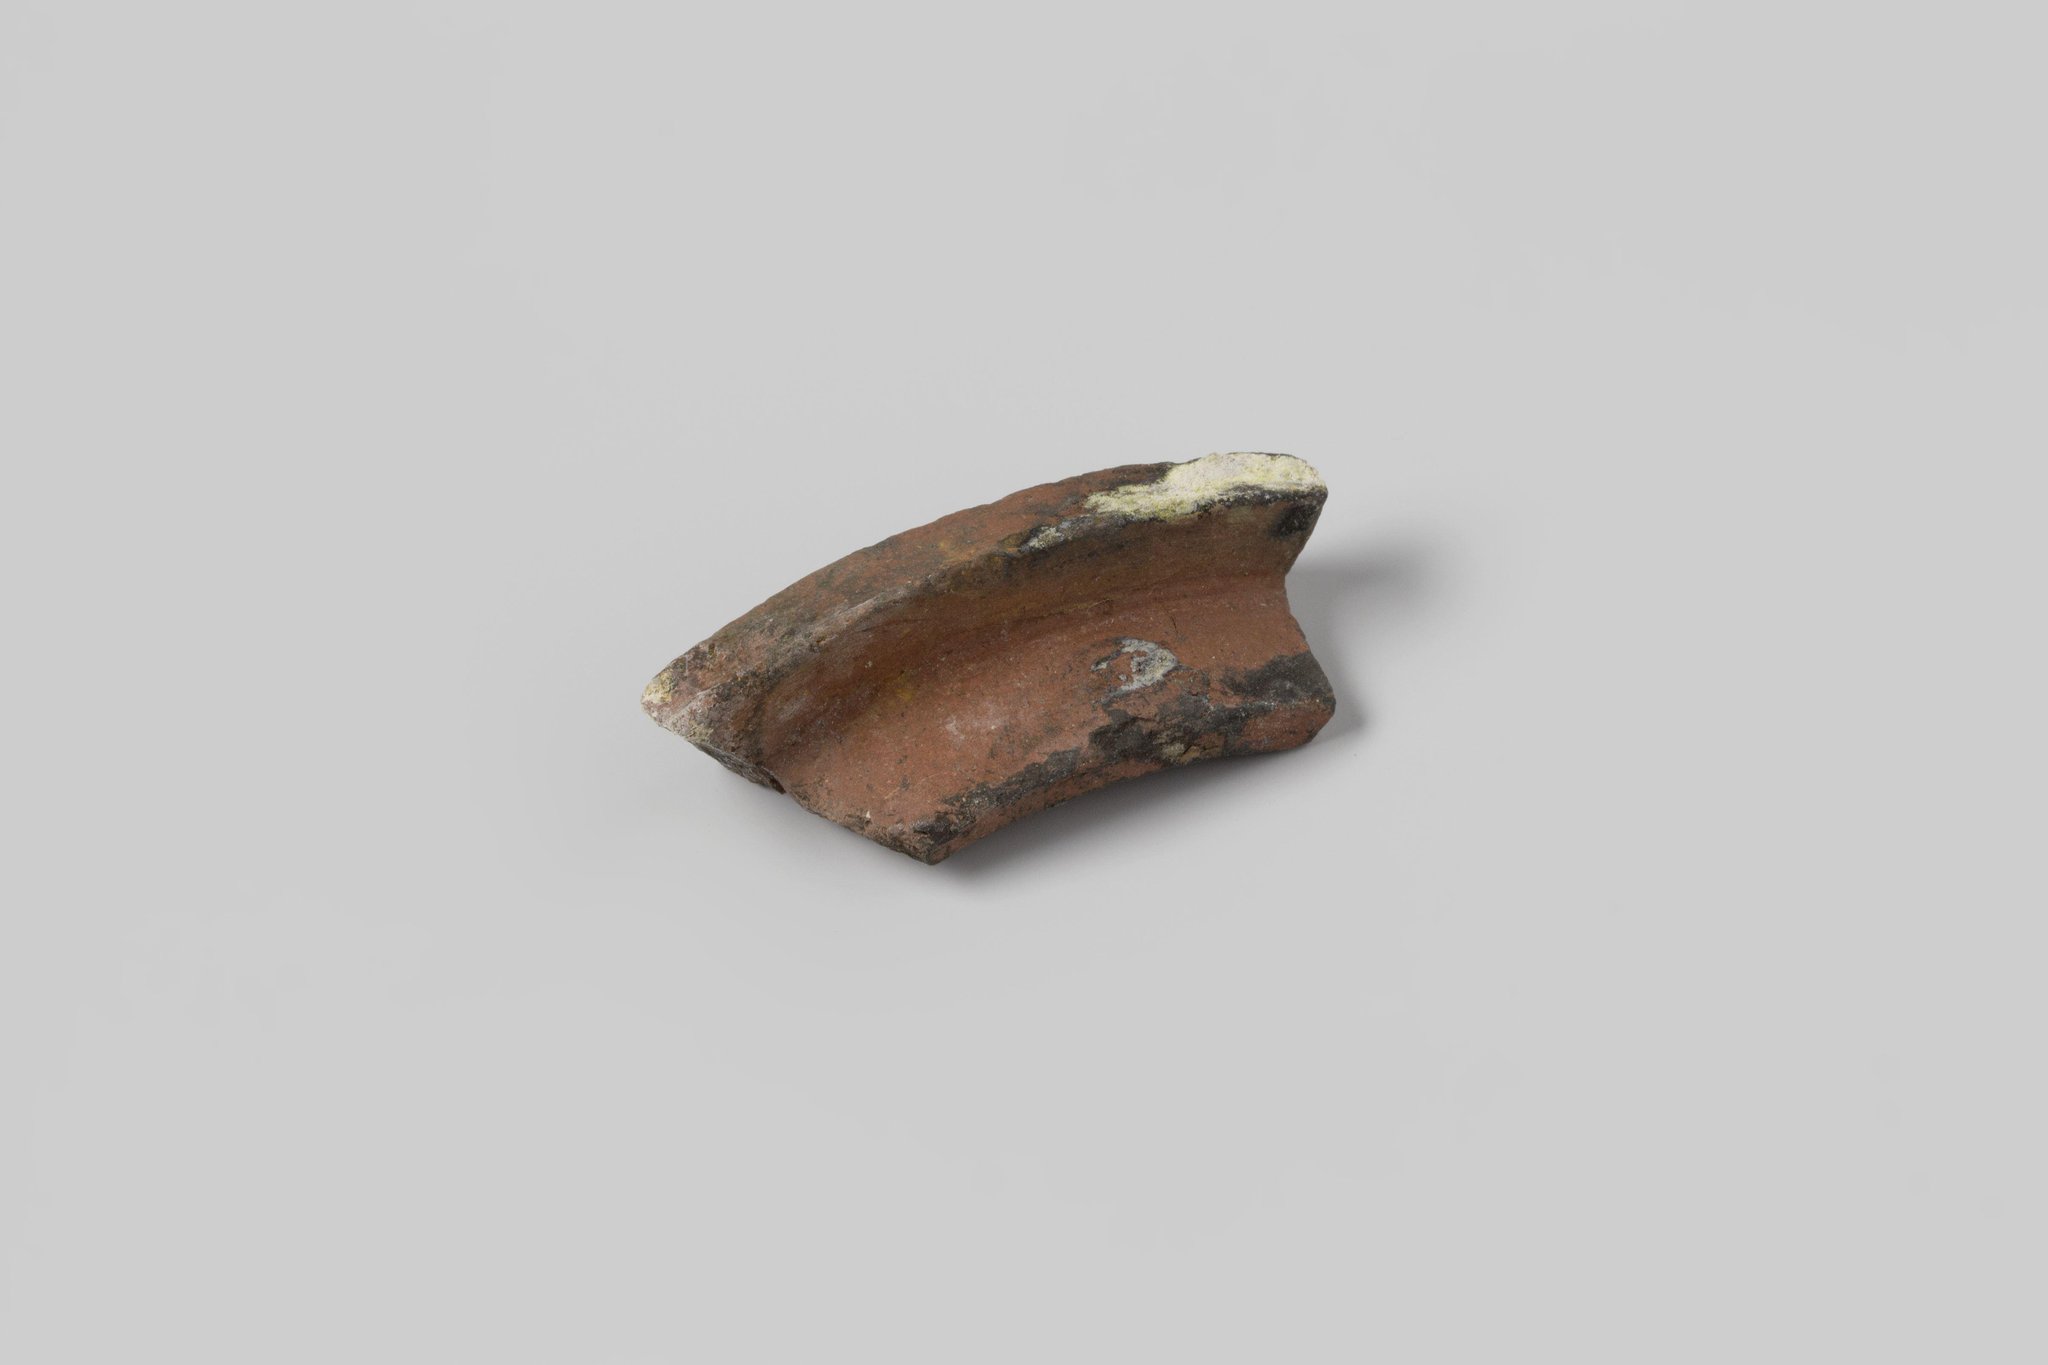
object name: sherd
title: Scherf van een Chinese theepot uit het wrak van de Oost-Indiëvaarder Hollandia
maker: Anonymous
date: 1700-1743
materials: earthenware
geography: china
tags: verenigde oostindische compagnie, hollandia (schip), annet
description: Stoneware, Chinese teapot; fragm of detachable rim, consisting of vertical ring with a flat overhanging rim.